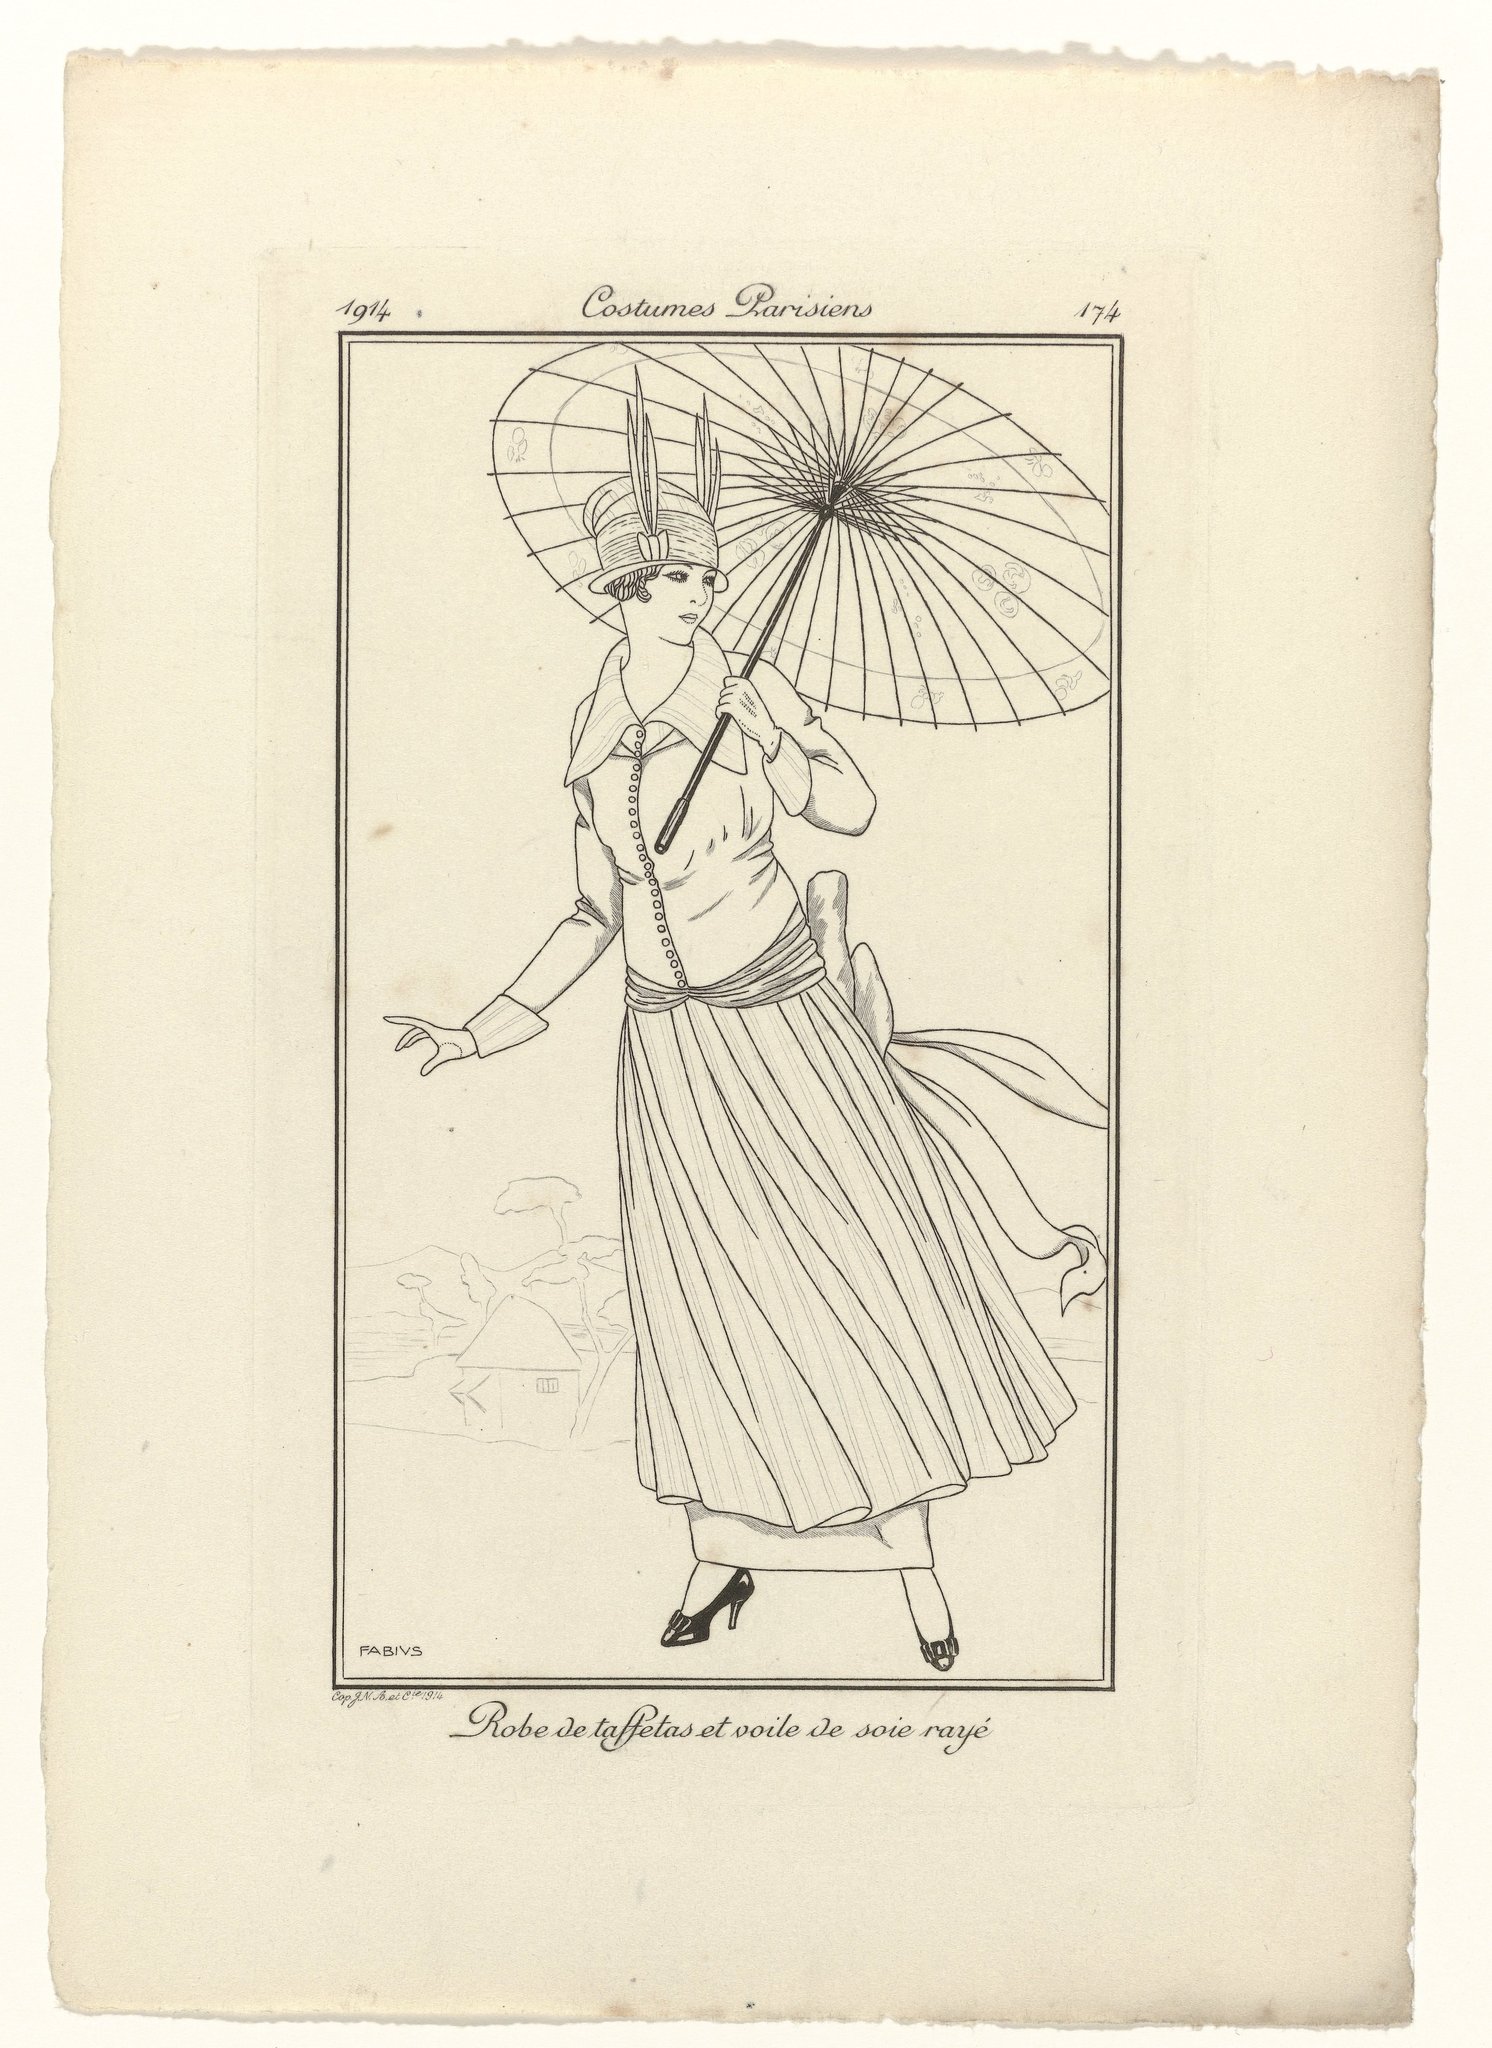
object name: fashion print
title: Journal des Dames et des Modes, Costumes Parisiens, 1914, No. 174 : Robe de taffetas (...)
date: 1914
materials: paper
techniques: engraving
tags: fashion plates, head-gear: hat (+ women's clothes), dress, gown (+ women's clothes), parasol, sunshade (+ women's clothes)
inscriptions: inscription: ‘Cop. J. N. A. et Cie 1914’, title: ‘Costumes Parisiens’, caption: ‘Robe de taffetas et voile de soie rayé’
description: Vrouw in een japon van tafzijde en gestreepte 'voile de soie'. Chinese of Japanse parasol in de hand. Proefdruk van een prent uit het modetijdschrift Journal des Dames et des Modes (1912-1914).